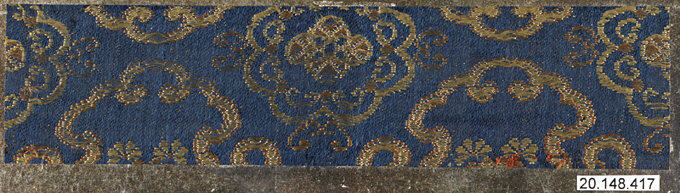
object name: piece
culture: japanese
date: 1701-1800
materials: silk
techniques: compound weave